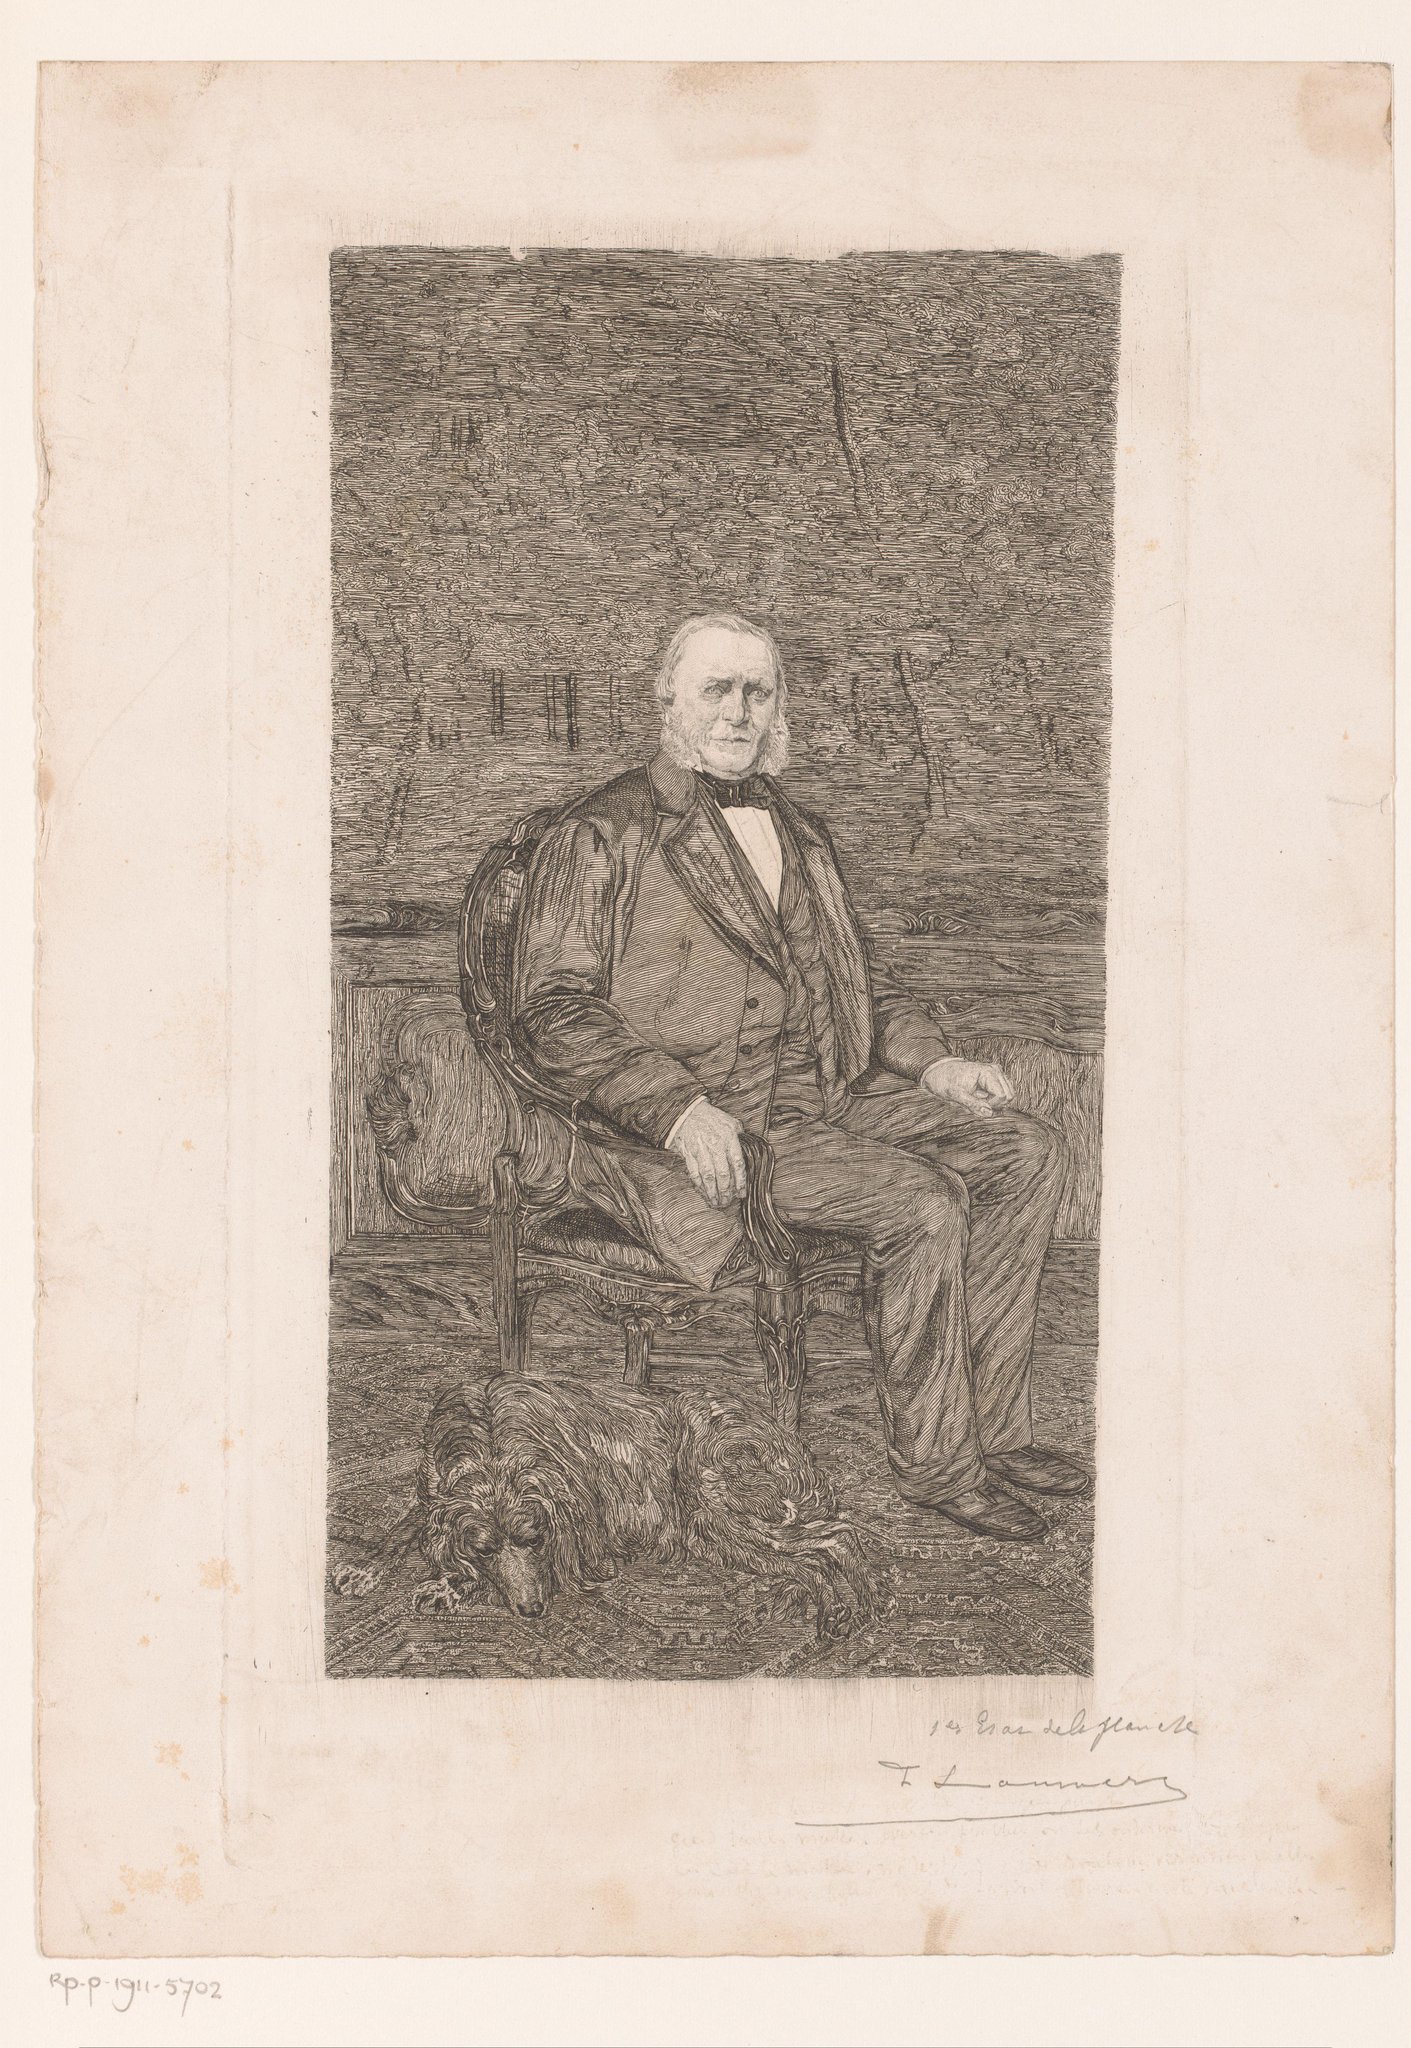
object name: print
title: Portret van een onbekende man, mogelijk senator Van den Berge Elsen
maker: frans lauwers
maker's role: print maker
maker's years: 1854-1931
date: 1864-1911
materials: paper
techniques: etching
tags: historical persons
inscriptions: annotation: ‘1er etat de la planche’, collector's mark: Lugt 2228